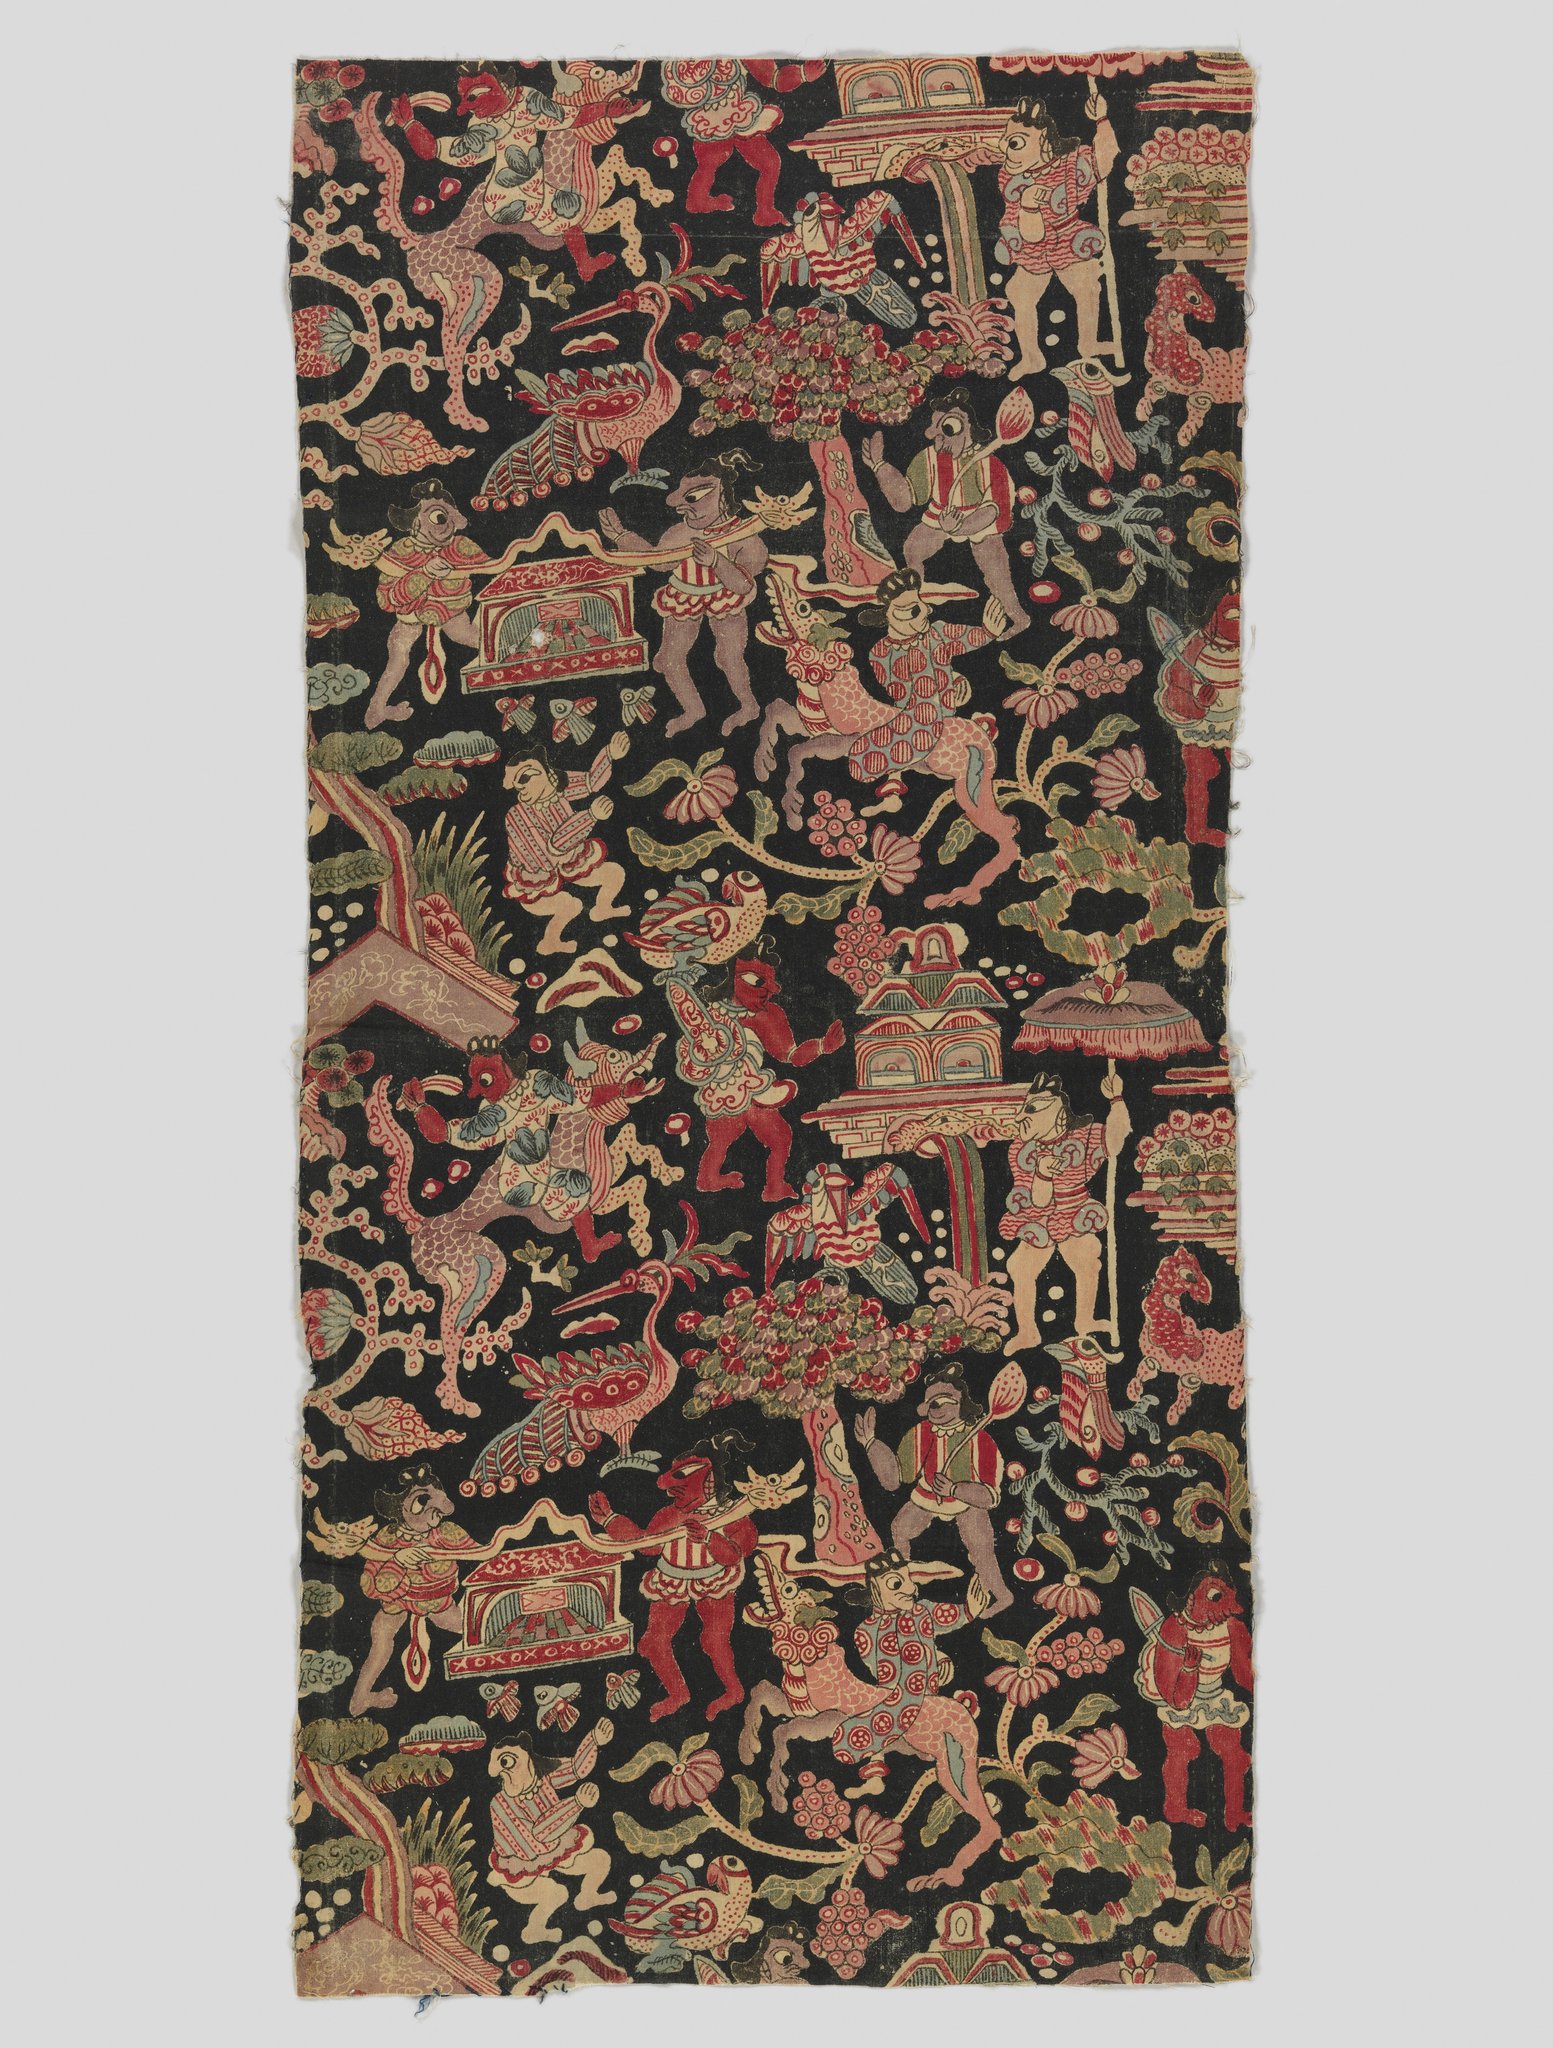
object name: sarasa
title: Sarasa with Figures, Birds, and Fantastic Animals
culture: indian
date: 1667-1733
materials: cotton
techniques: dyeing, painting, resist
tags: human figures,birds,mythical creatures,flowers